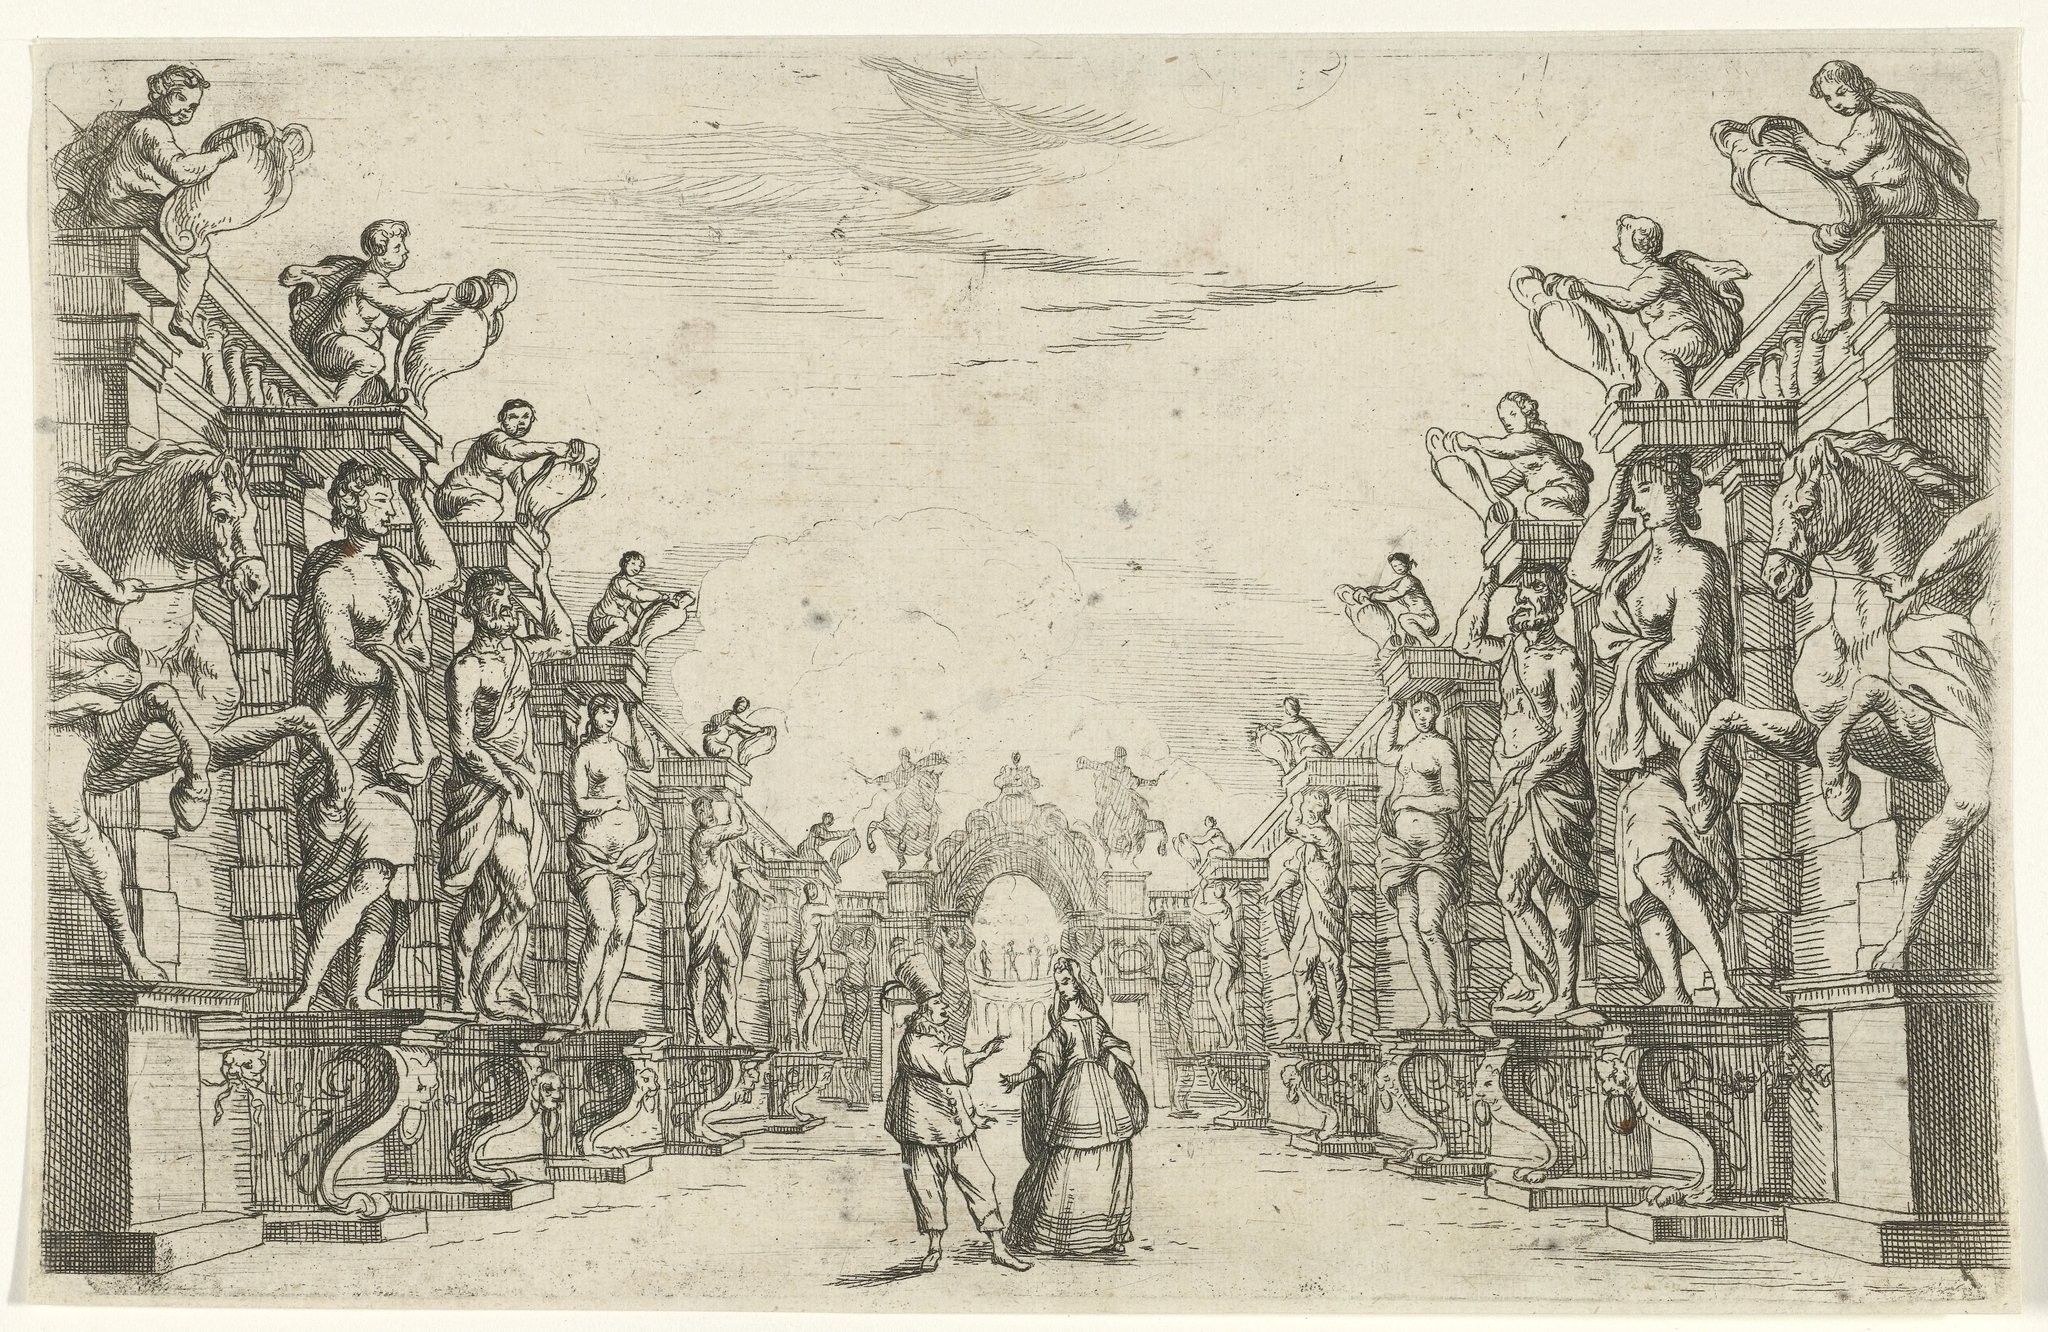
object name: print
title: Man en vrouw in een galerij met kariatiden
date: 1663-1674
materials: paper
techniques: etching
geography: vienna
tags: set, scenery ~ stage, theatre, theatrical performance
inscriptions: collector's mark: Lugt 2228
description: Een man en een vrouw lopen in het midden van een galerij met kariatiden. Aan het begin van de galerij staan twee ruiterstandbeelden, aan het einde een poort.